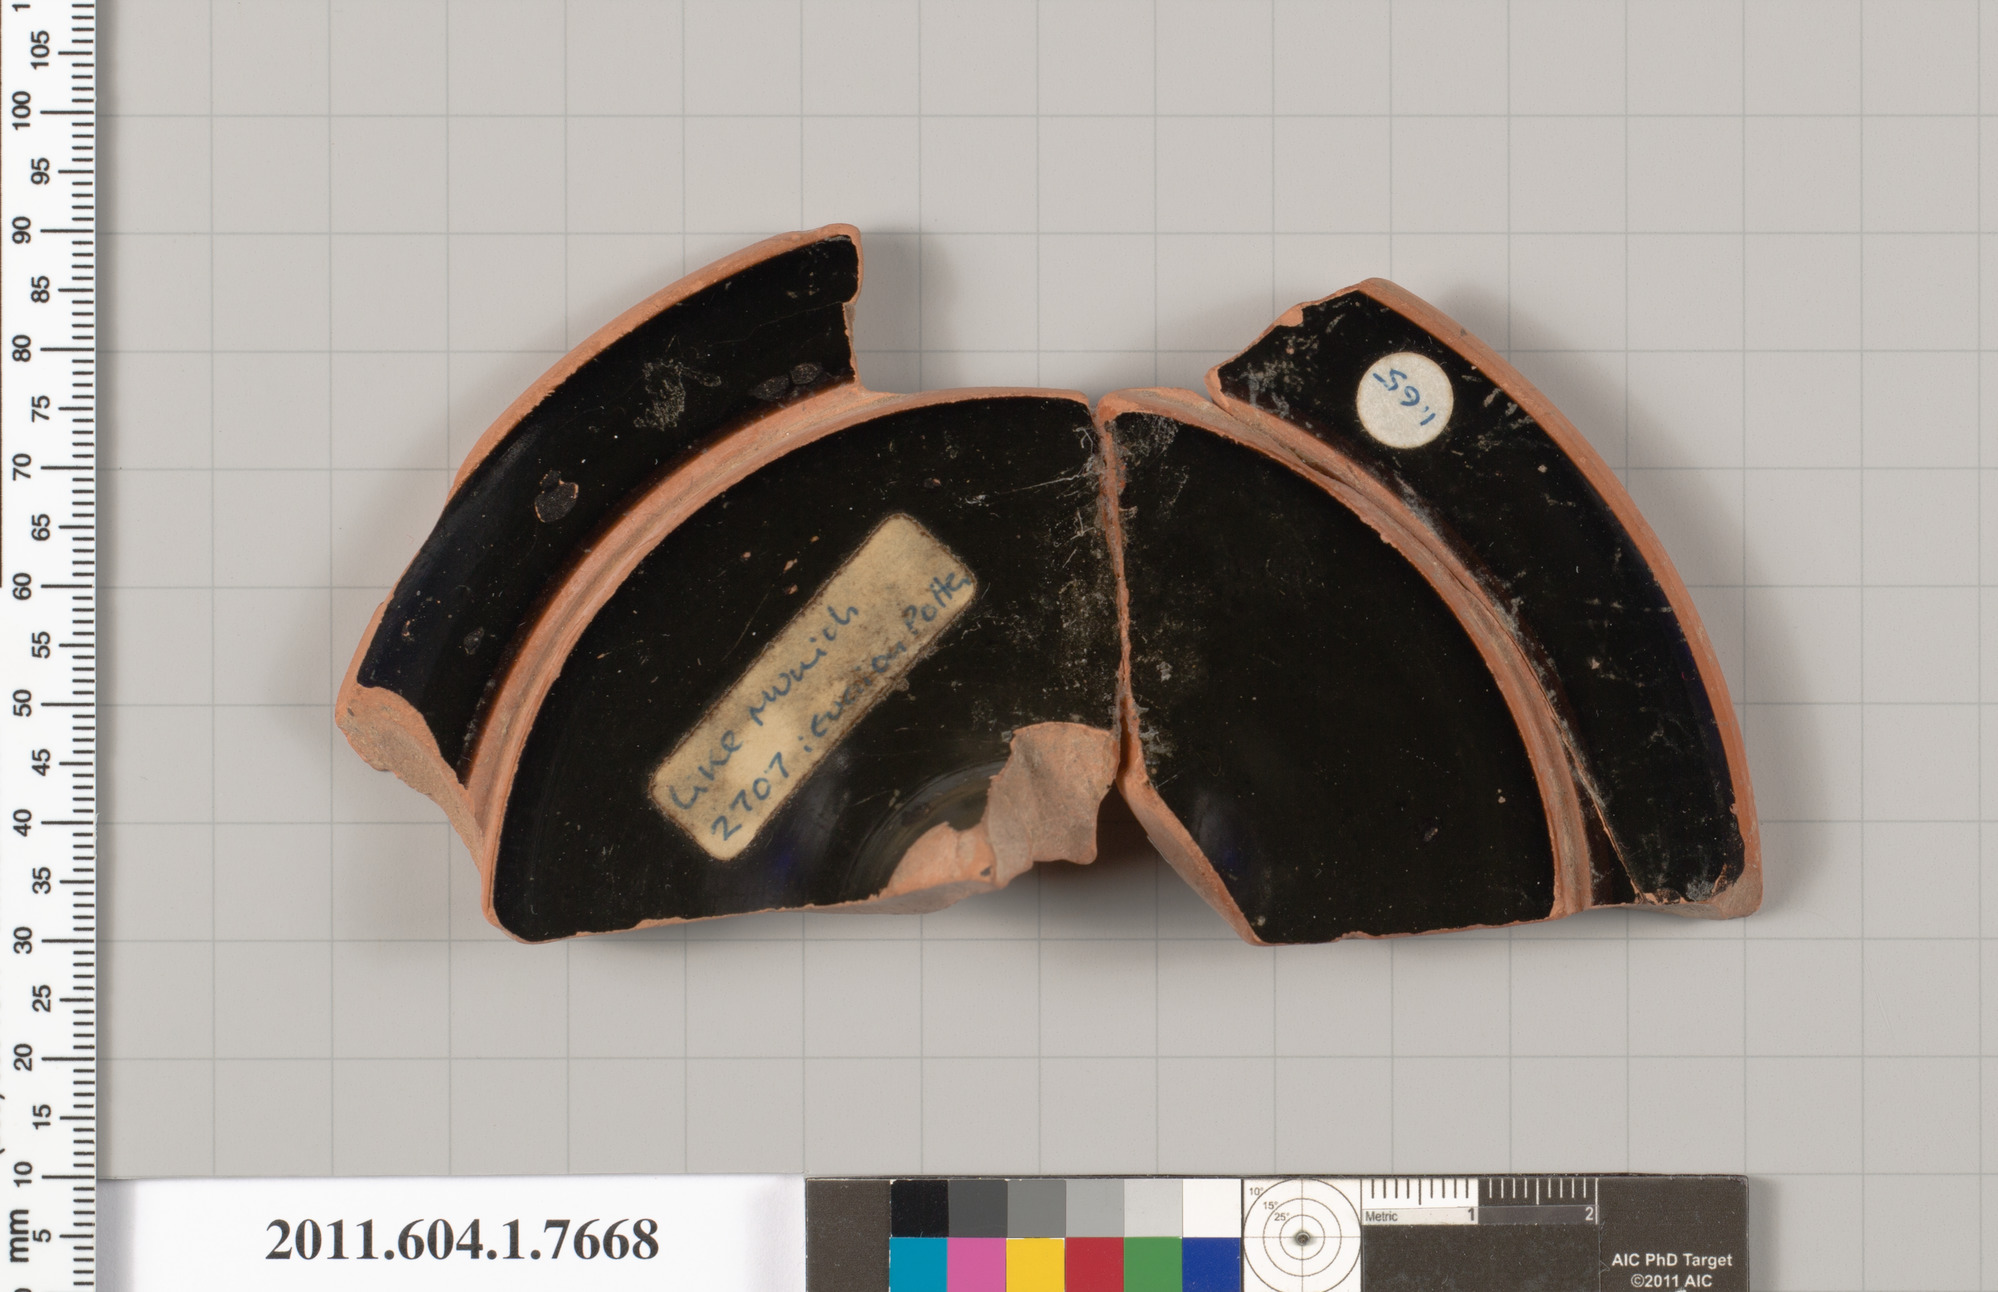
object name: kylix fragment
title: Terracotta fragment of a kylix (drinking cup)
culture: greek, attic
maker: euaion, potter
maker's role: artist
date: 460-450 BCE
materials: terracotta